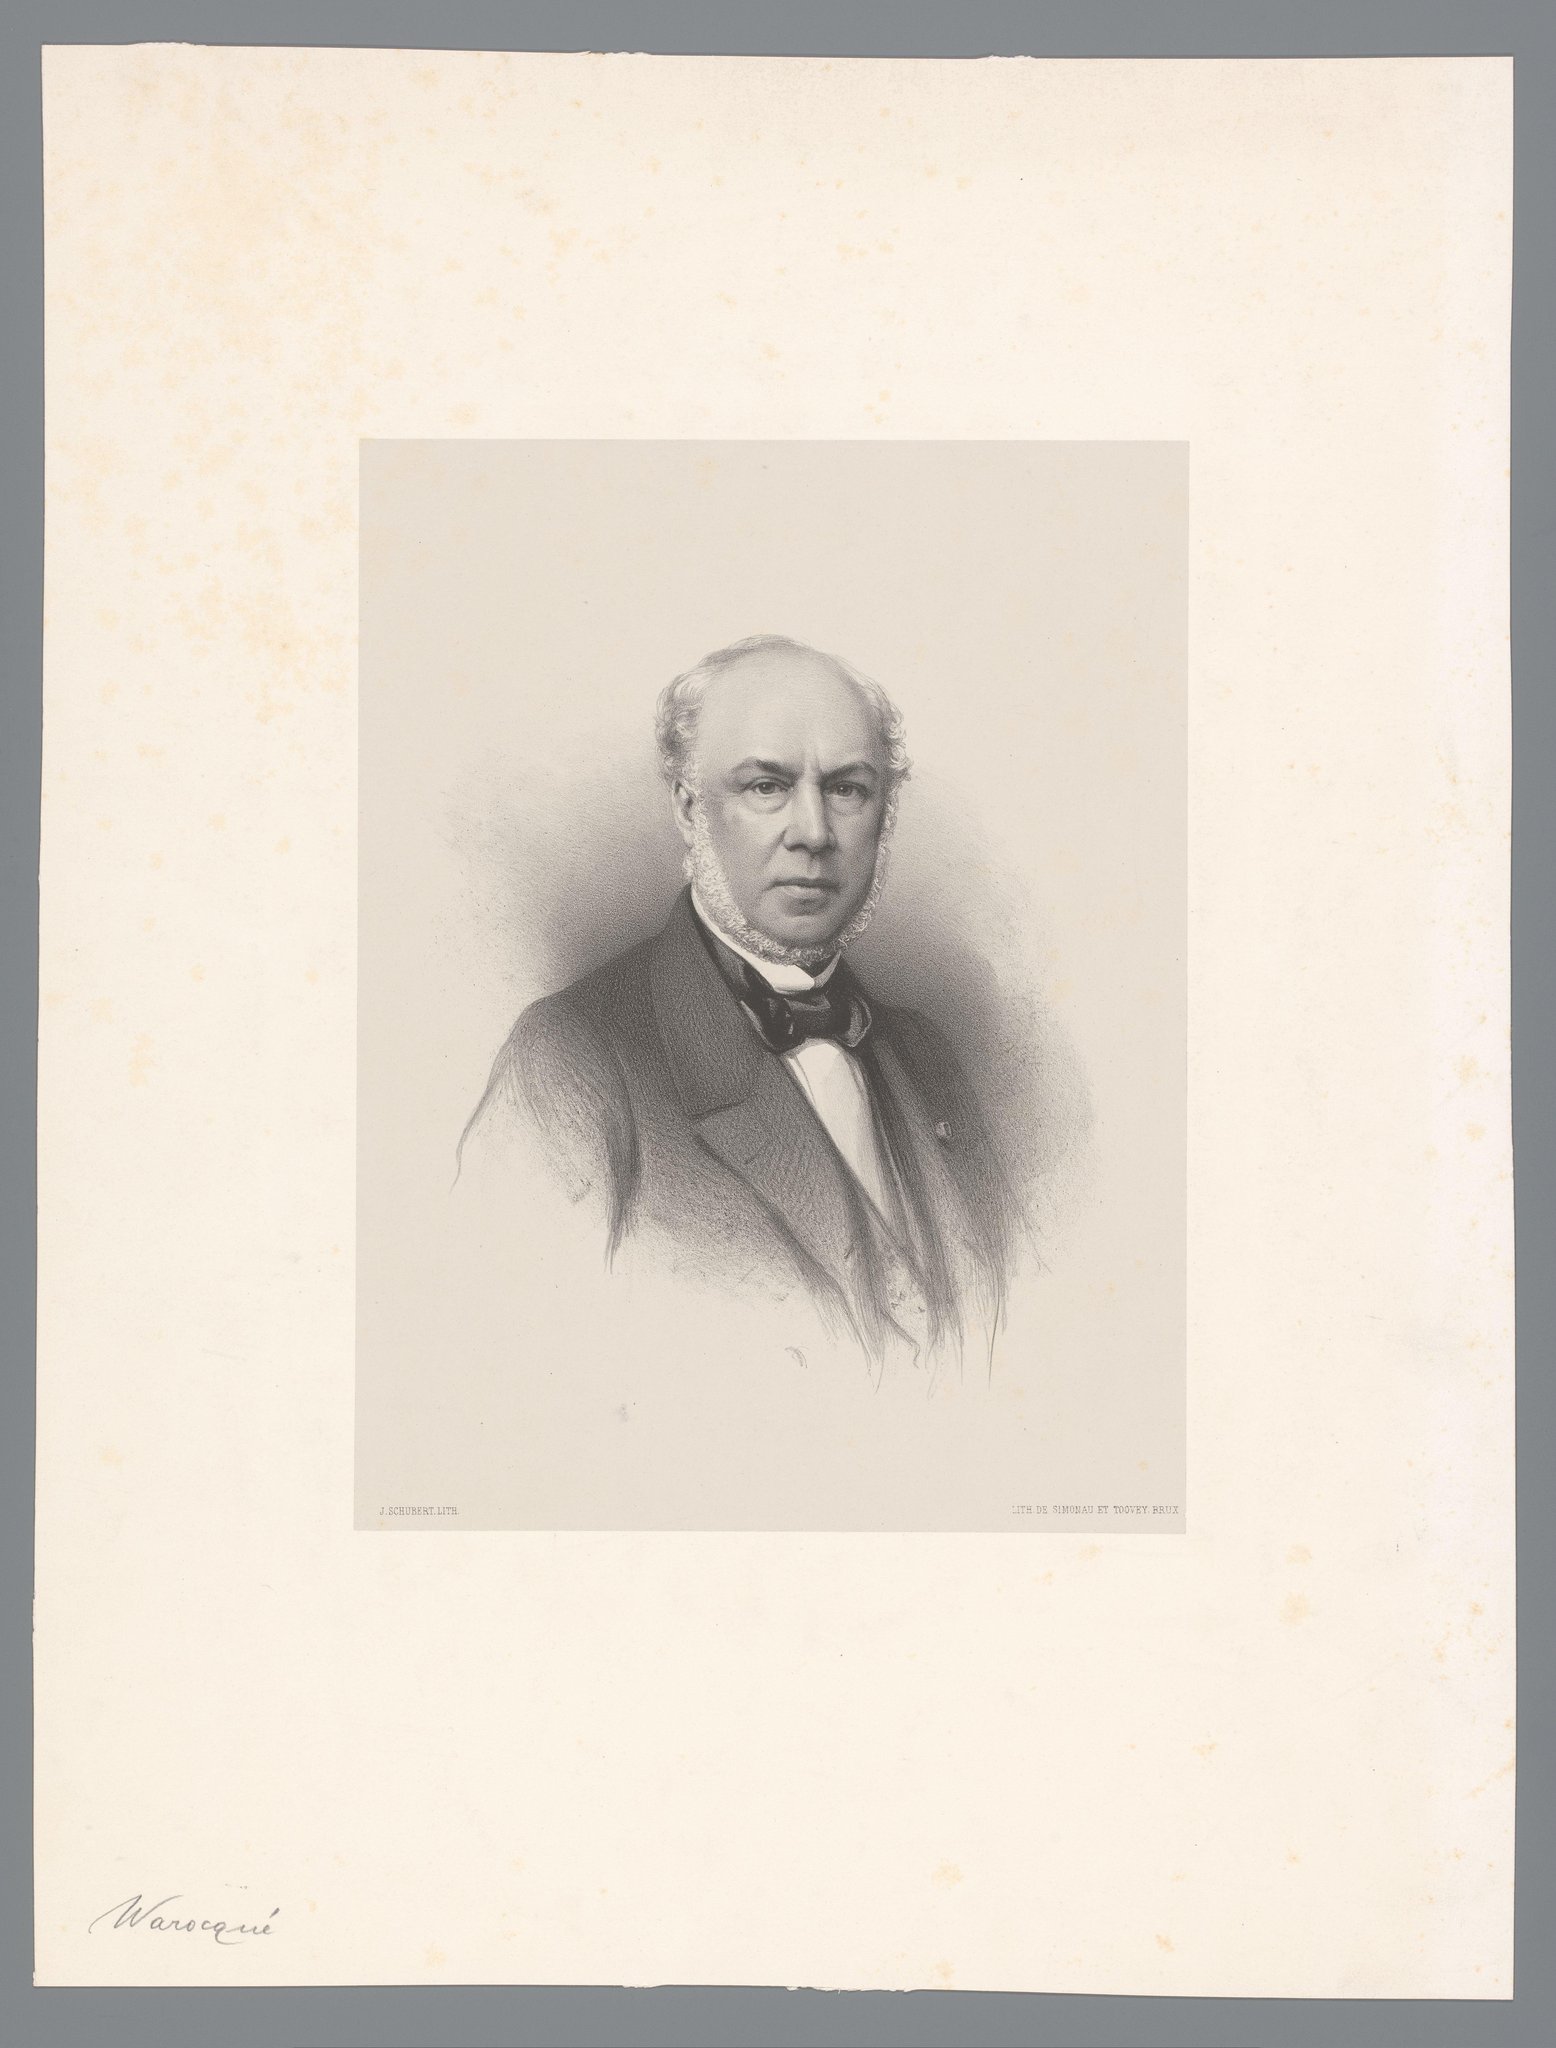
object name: print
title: Portret van Abel Warocqué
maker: joseph schubert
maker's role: print maker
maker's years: 1816-1885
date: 1847-1885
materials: paper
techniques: lithograph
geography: brussels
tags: mayor, mayor, burgomaster, historical persons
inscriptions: collector's mark: Lugt 2228